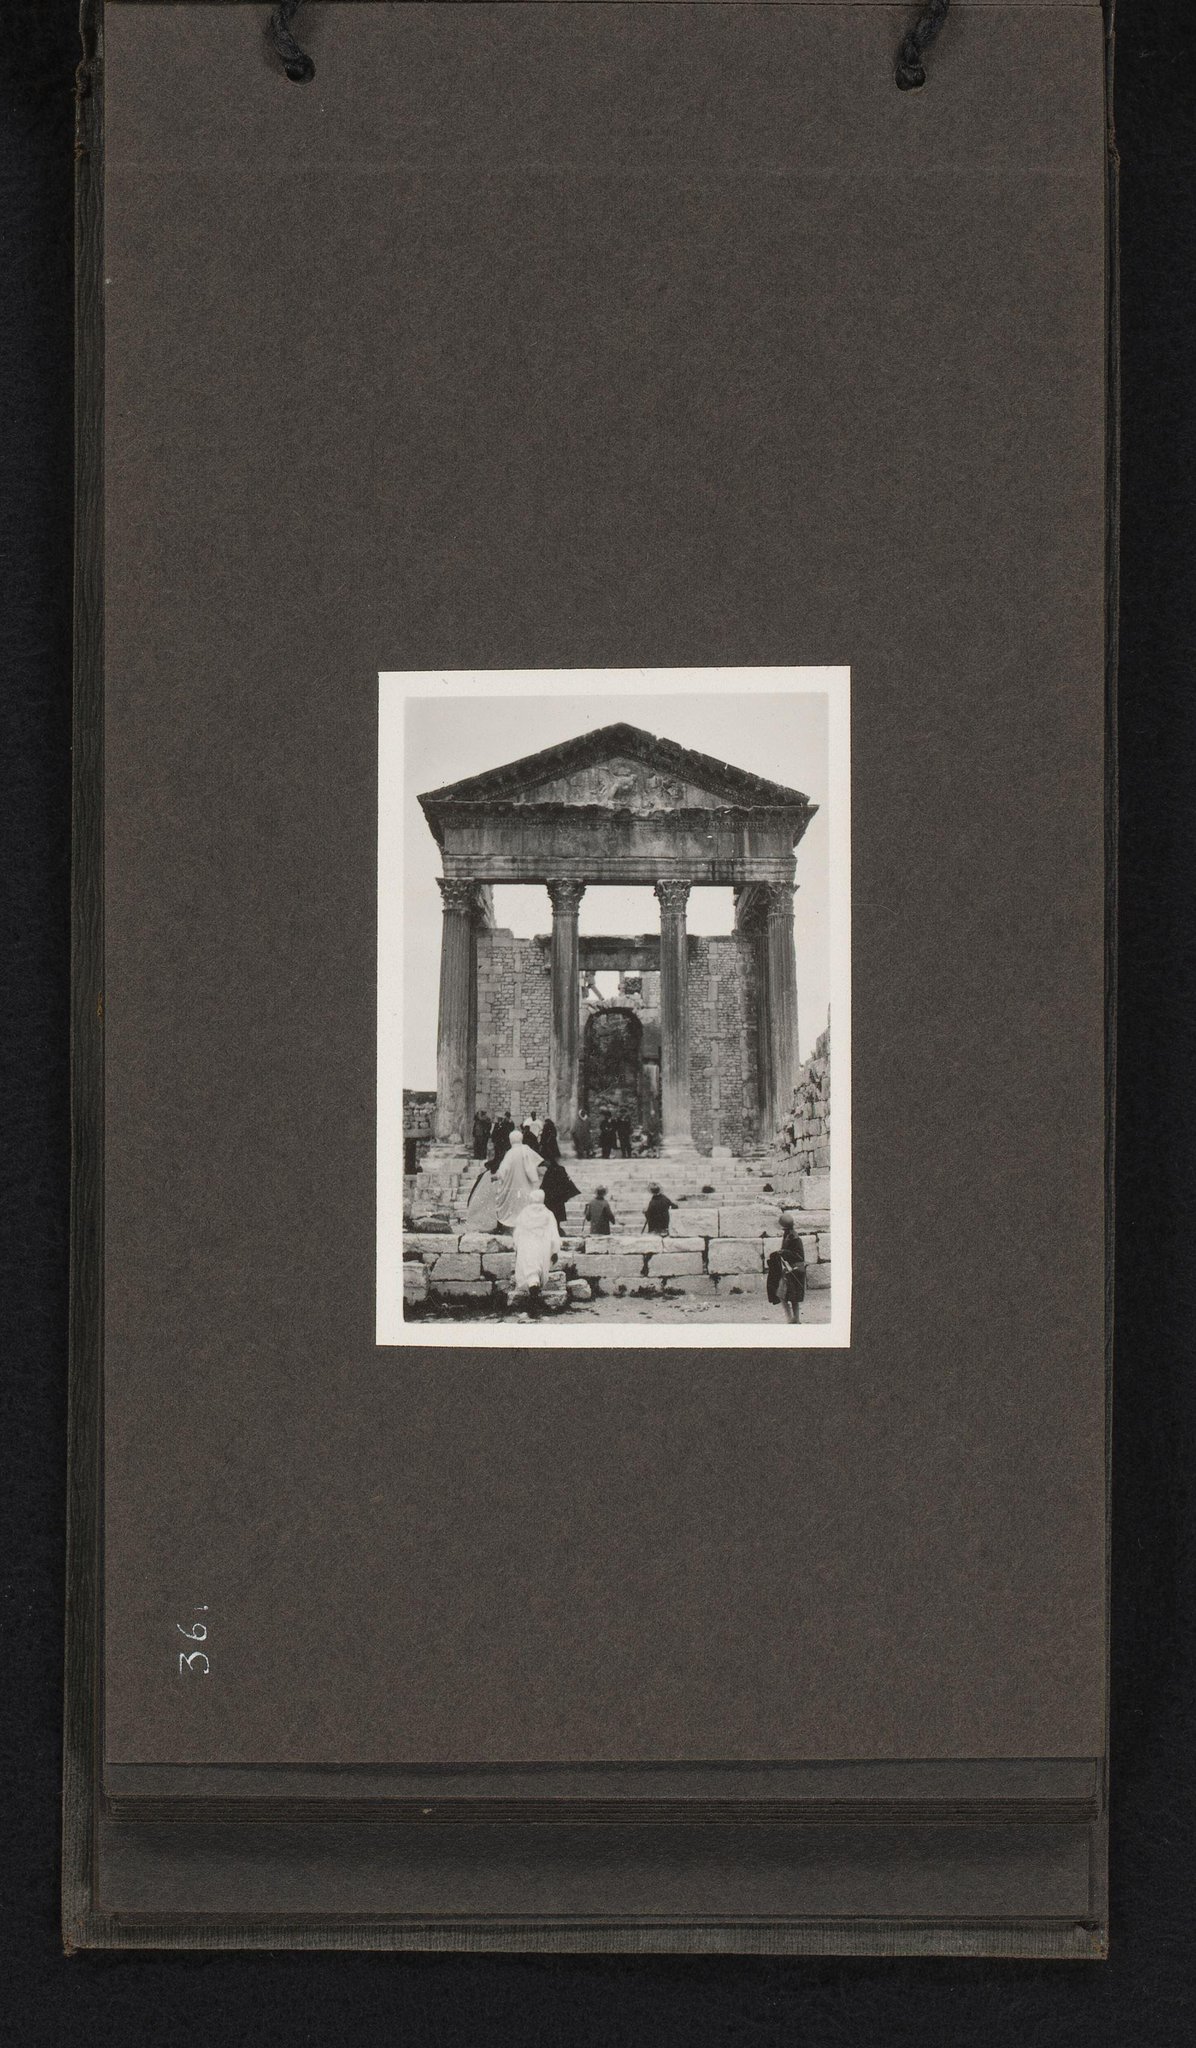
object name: photograph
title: Kapitool in Dougga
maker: a.g.a. van eelde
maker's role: engineer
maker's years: 1862-1950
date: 1927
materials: paper, photographic support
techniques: gelatin silver print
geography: dougga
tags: landscape with ruins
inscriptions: number: ‘36.’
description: Titel 'Kapitool' afkomstig uit de inventaris achterin het album.